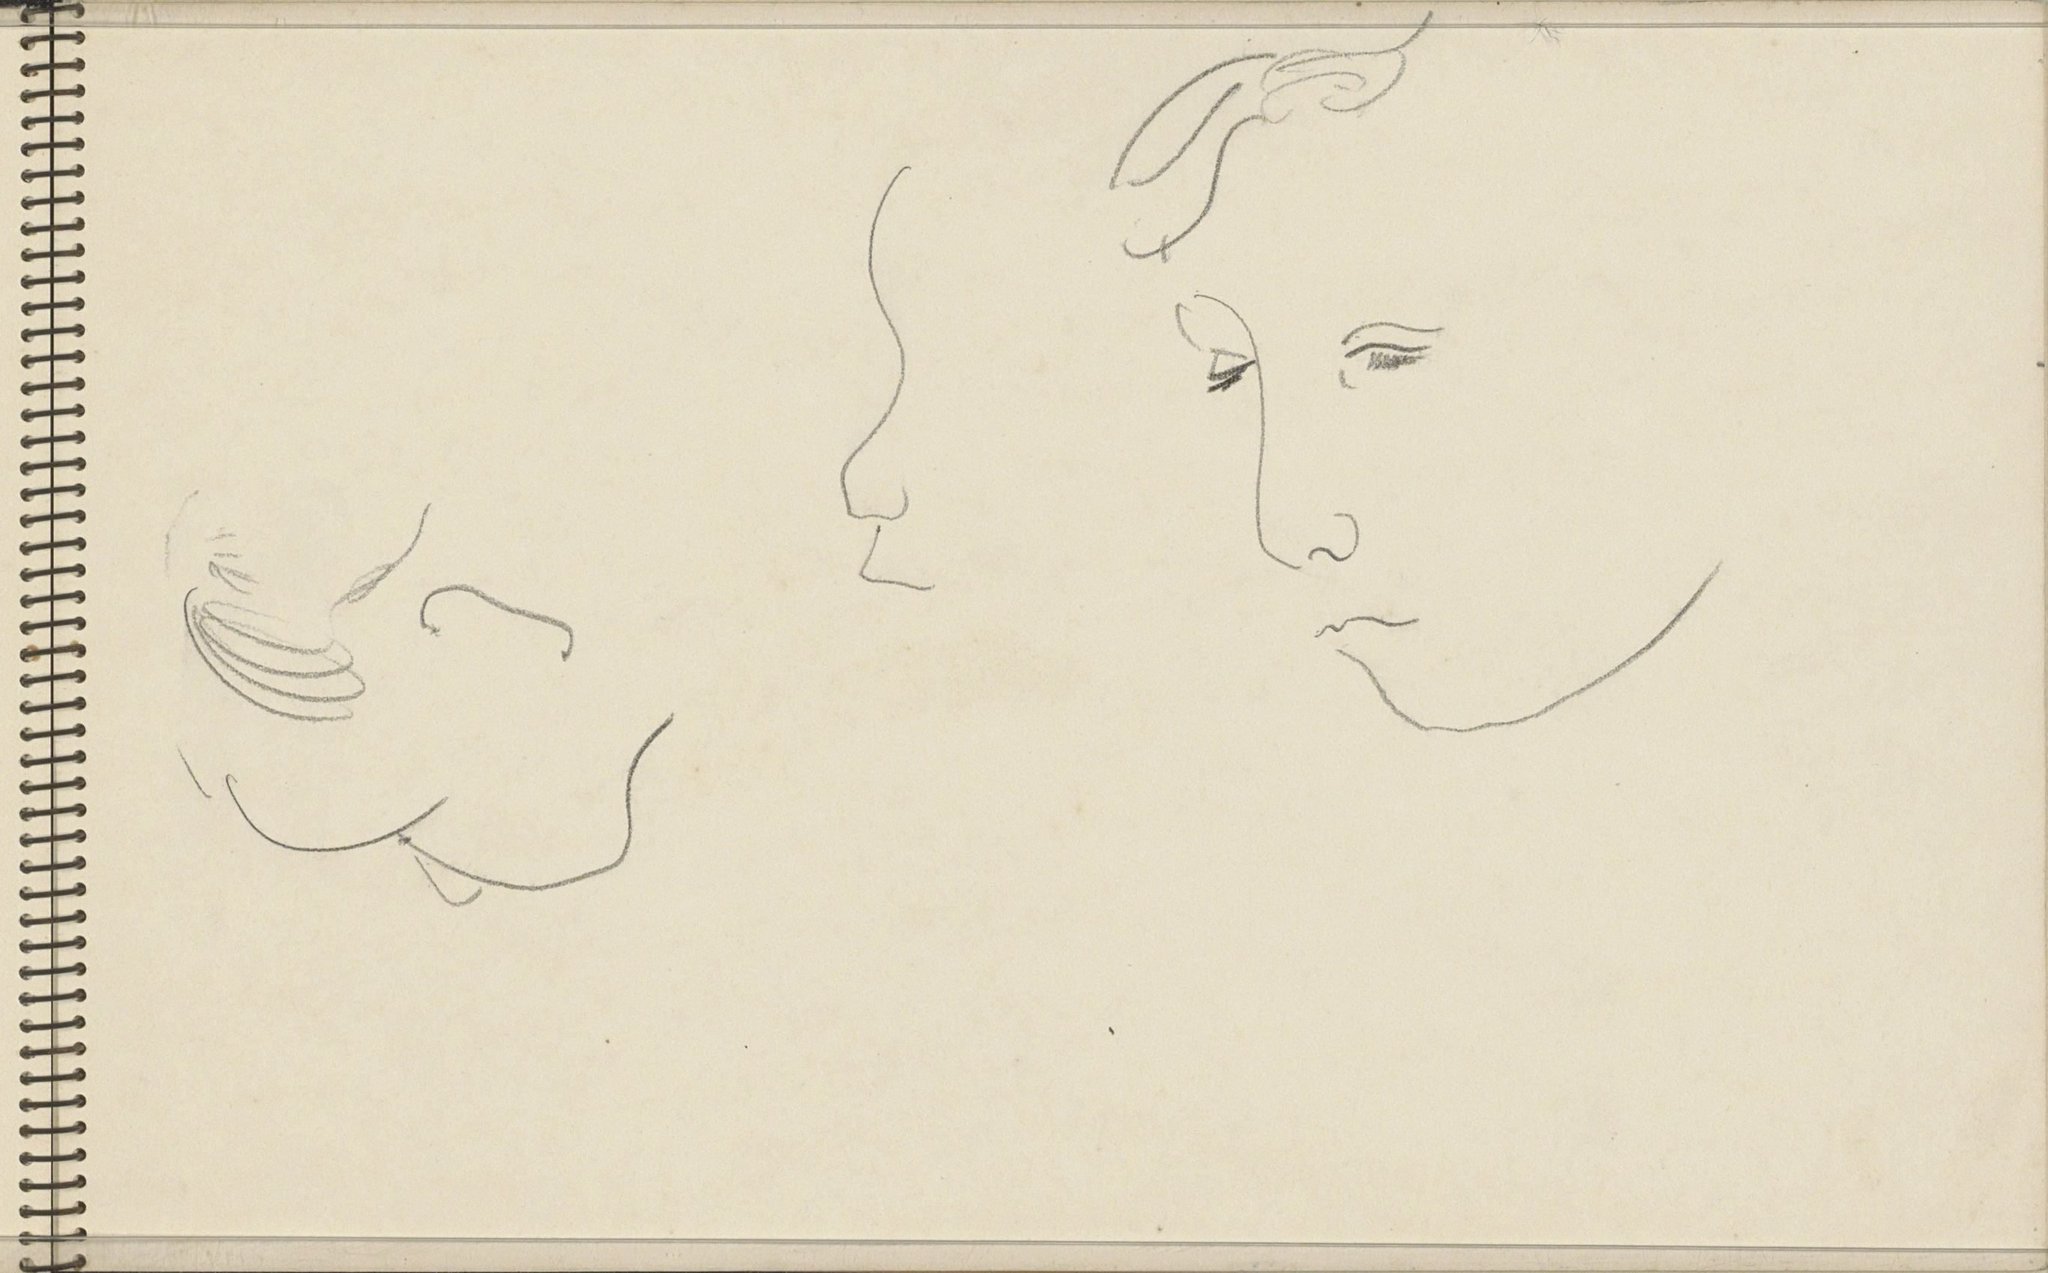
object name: sketchbook leaf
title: Koppen van een kind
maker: carel adolph lion cachet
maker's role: draughtsman, print maker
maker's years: 1864-1945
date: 1928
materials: paper, pencil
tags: head (human), child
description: Blad 6 recto uit een schetsboek met 12 bladen.